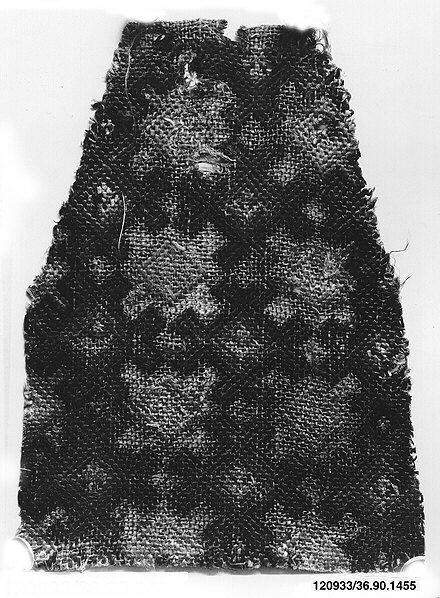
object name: piece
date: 1601-1700